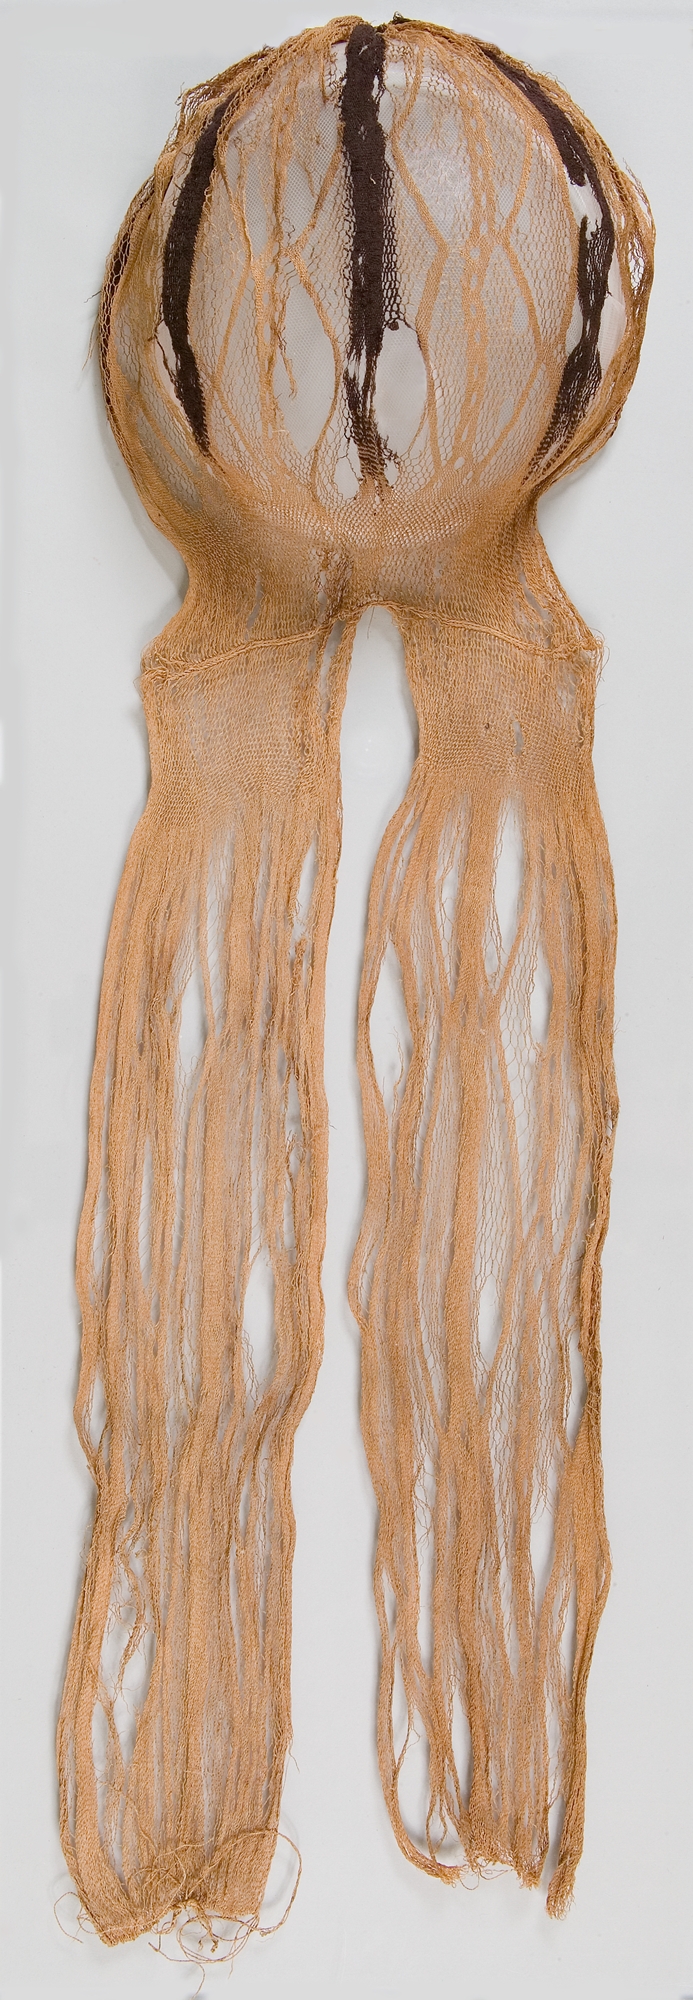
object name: turban, mummy of a child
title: Headdress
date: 101-333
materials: linen, wool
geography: northern upper egypt